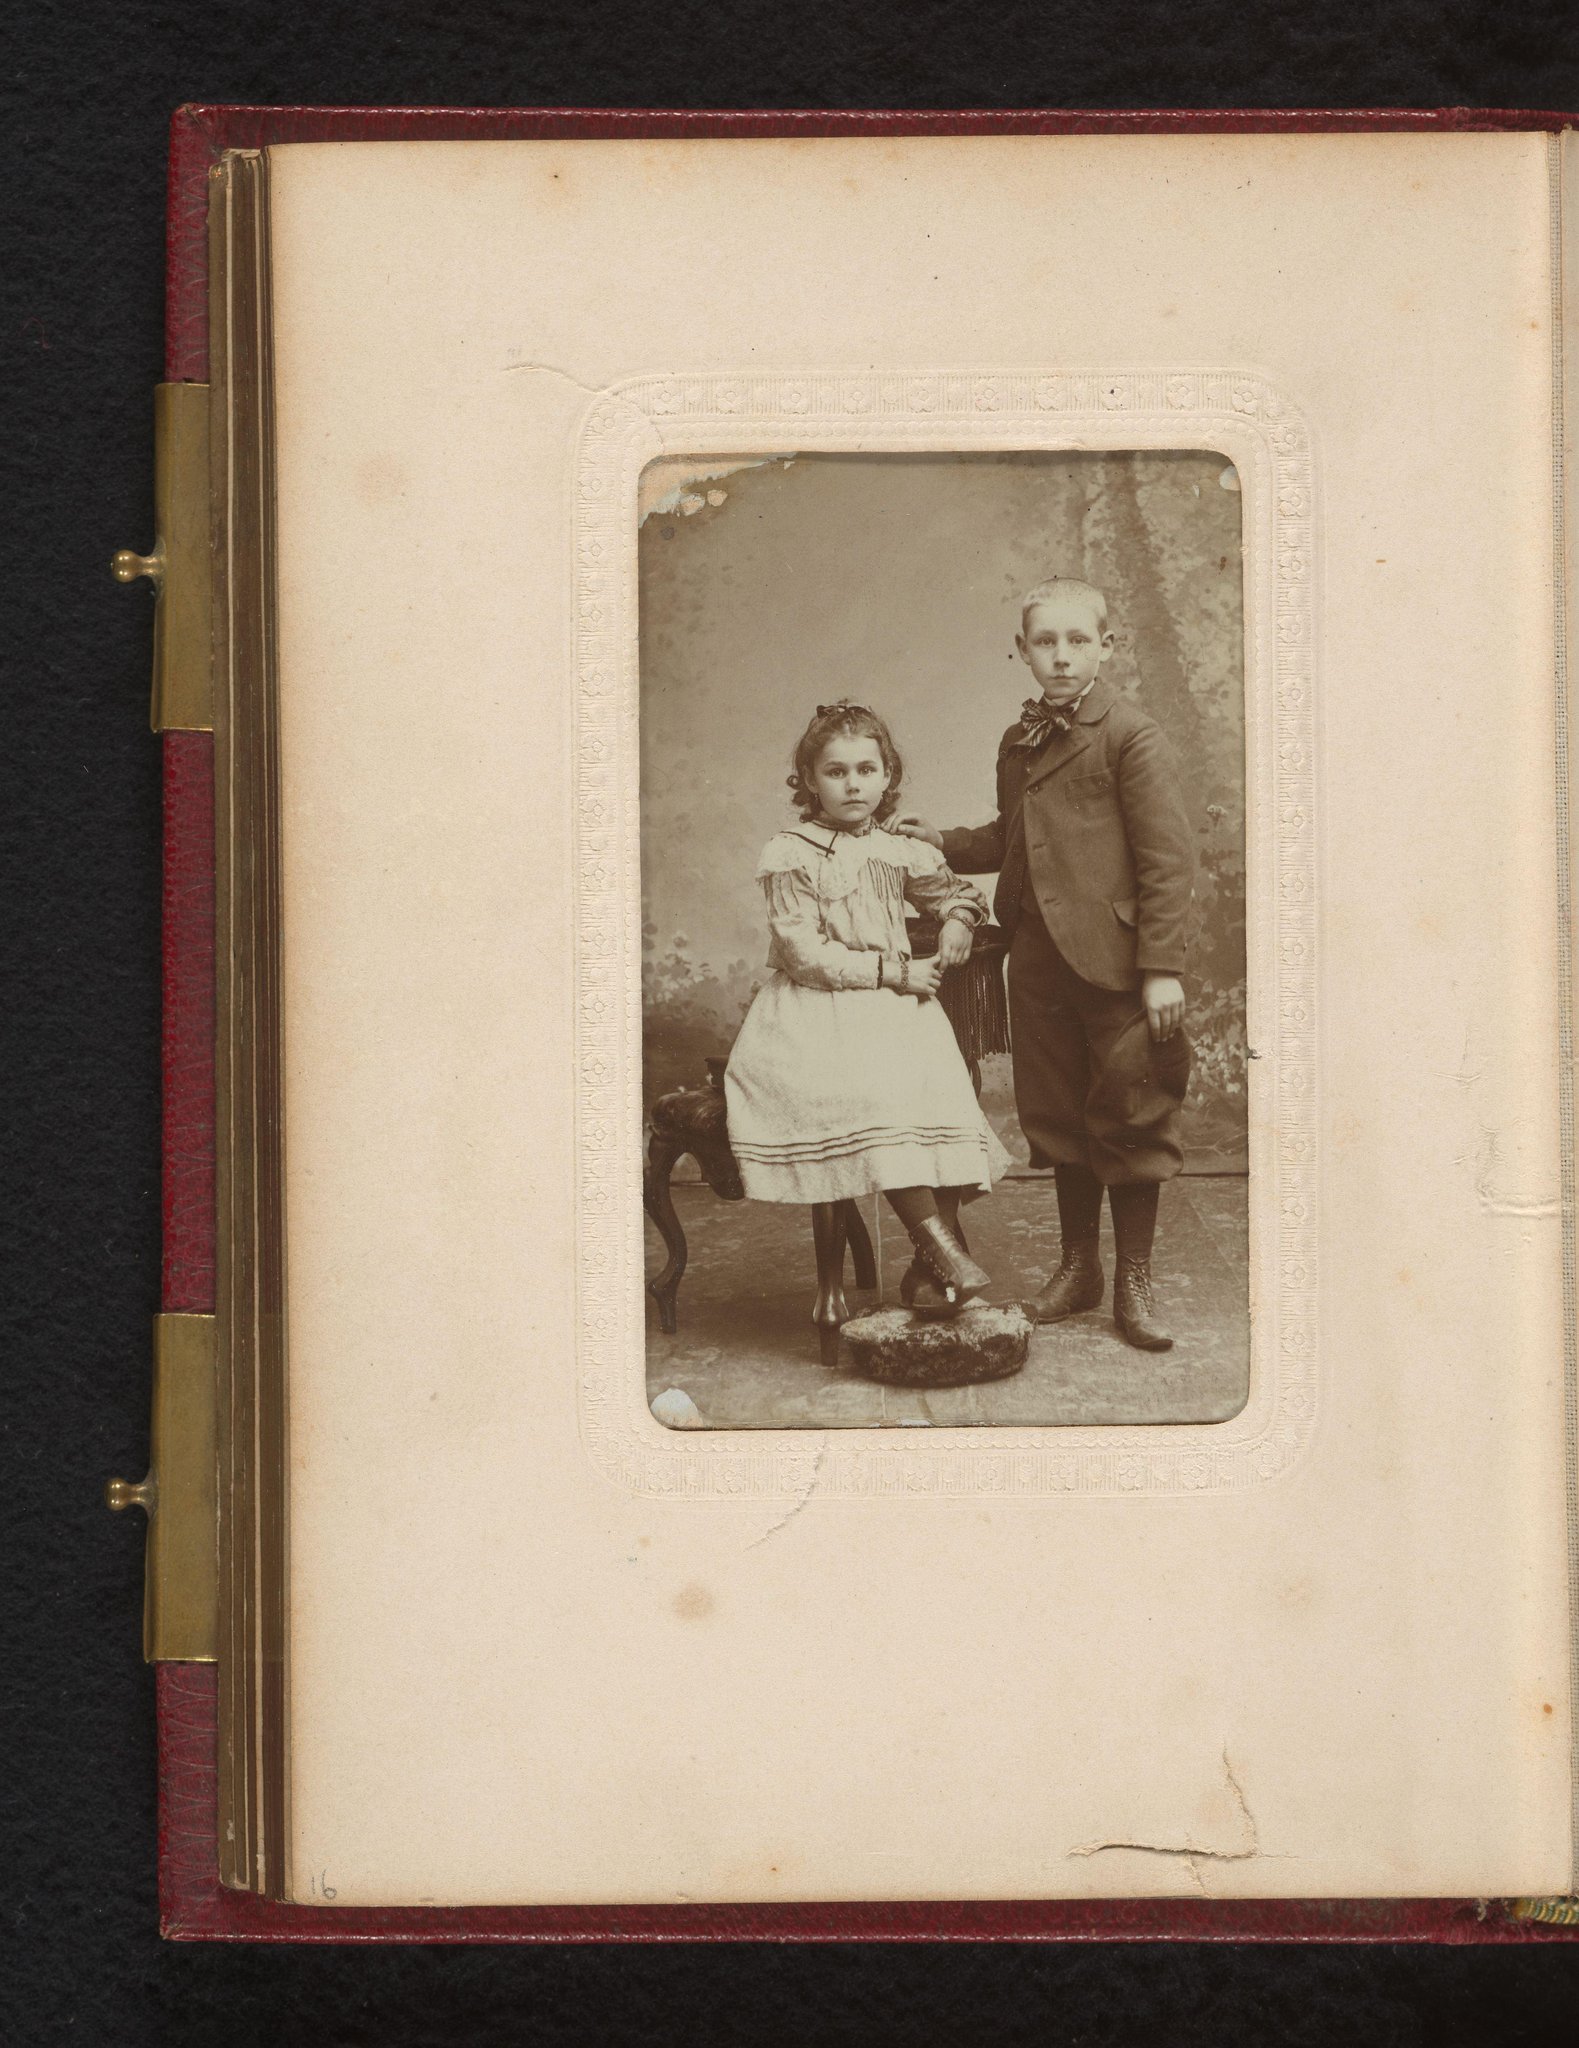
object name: album leaf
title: Portret van een zittend meisje en een staande jongen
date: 1900-1905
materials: cardboard, photographic support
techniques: collodion silver print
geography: leeuwarden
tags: historical persons - bb - woman, boy (child between toddler and youth), historical persons, girl (child between toddler and youth)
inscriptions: inscription: ‘Photographie/ Studio/ Groote Hoogstraat No 9/ naby de Brol/ Leeuwarden’